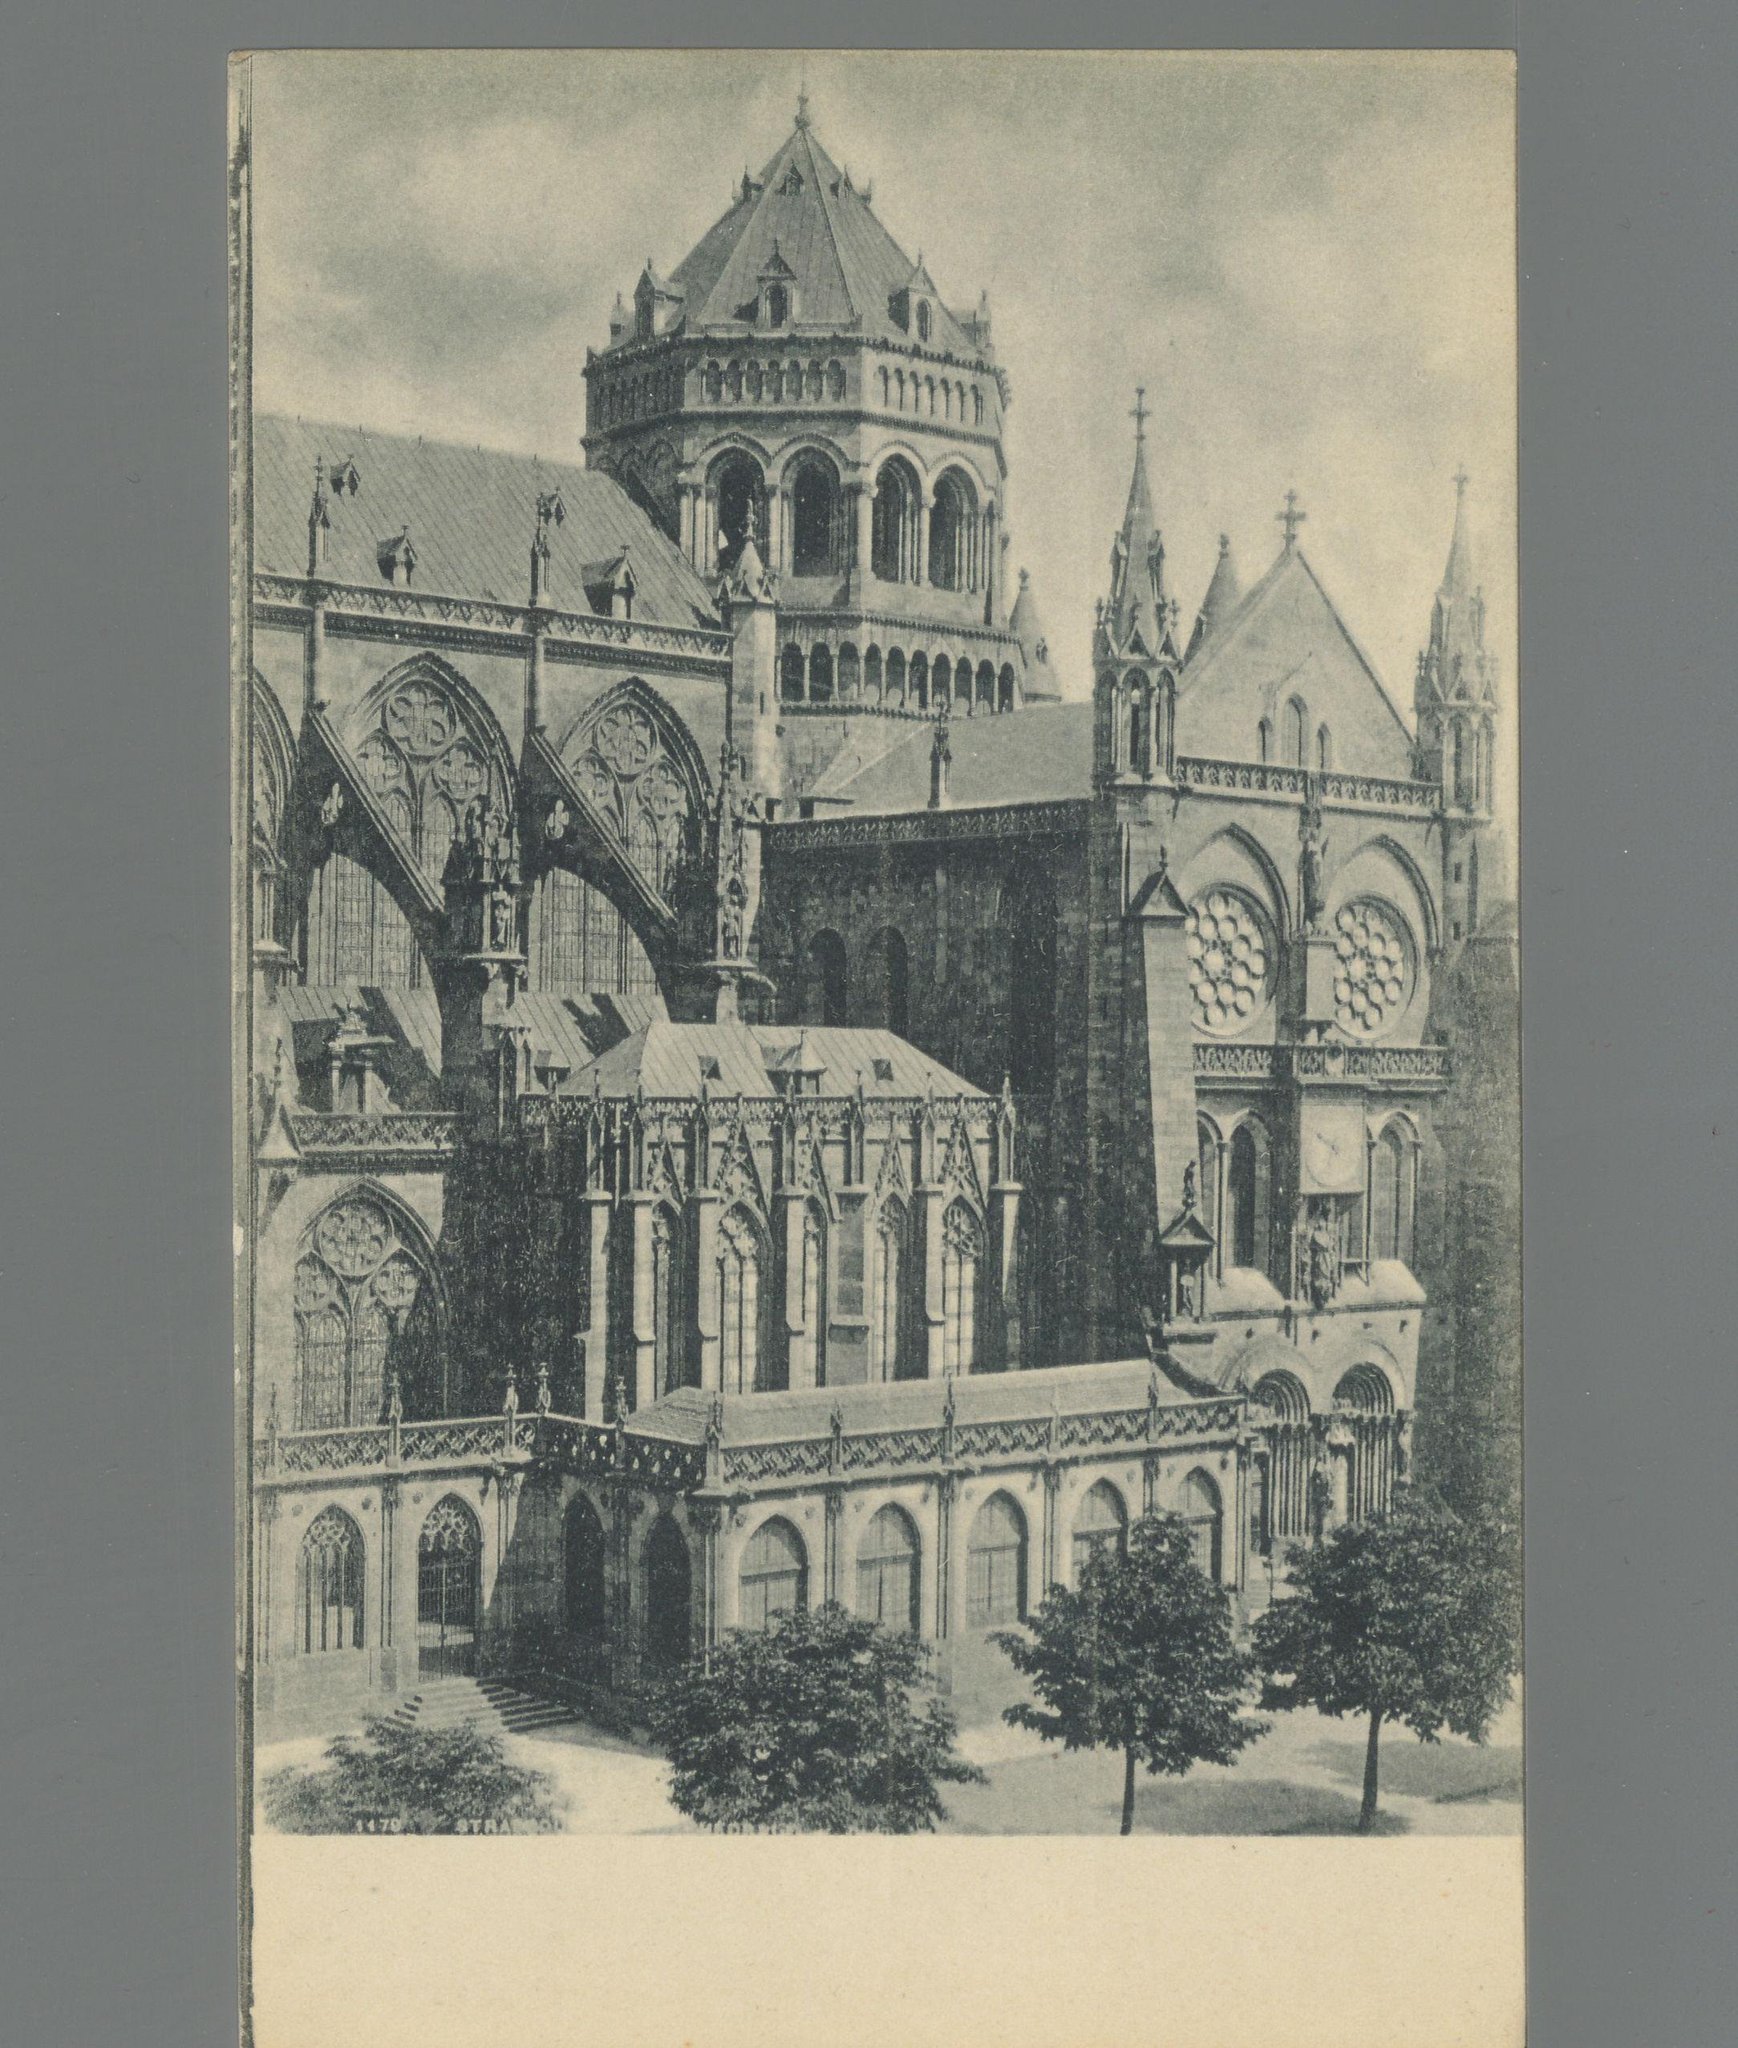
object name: photomechanical print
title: Strassburg - Der achteckige Turm und das Querhaus / Strasbourg - La Tour octogone et le Transept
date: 1885-1905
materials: cardboard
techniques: photograph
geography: straatsburg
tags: church (exterior), parts of church exterior and annexes: tower